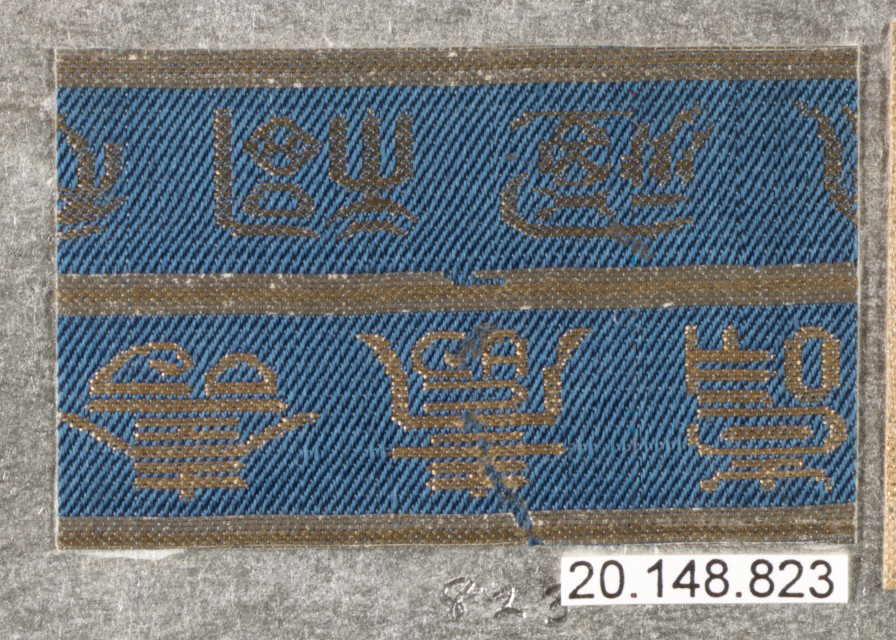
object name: piece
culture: japanese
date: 1701-1800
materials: silk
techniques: compound weave